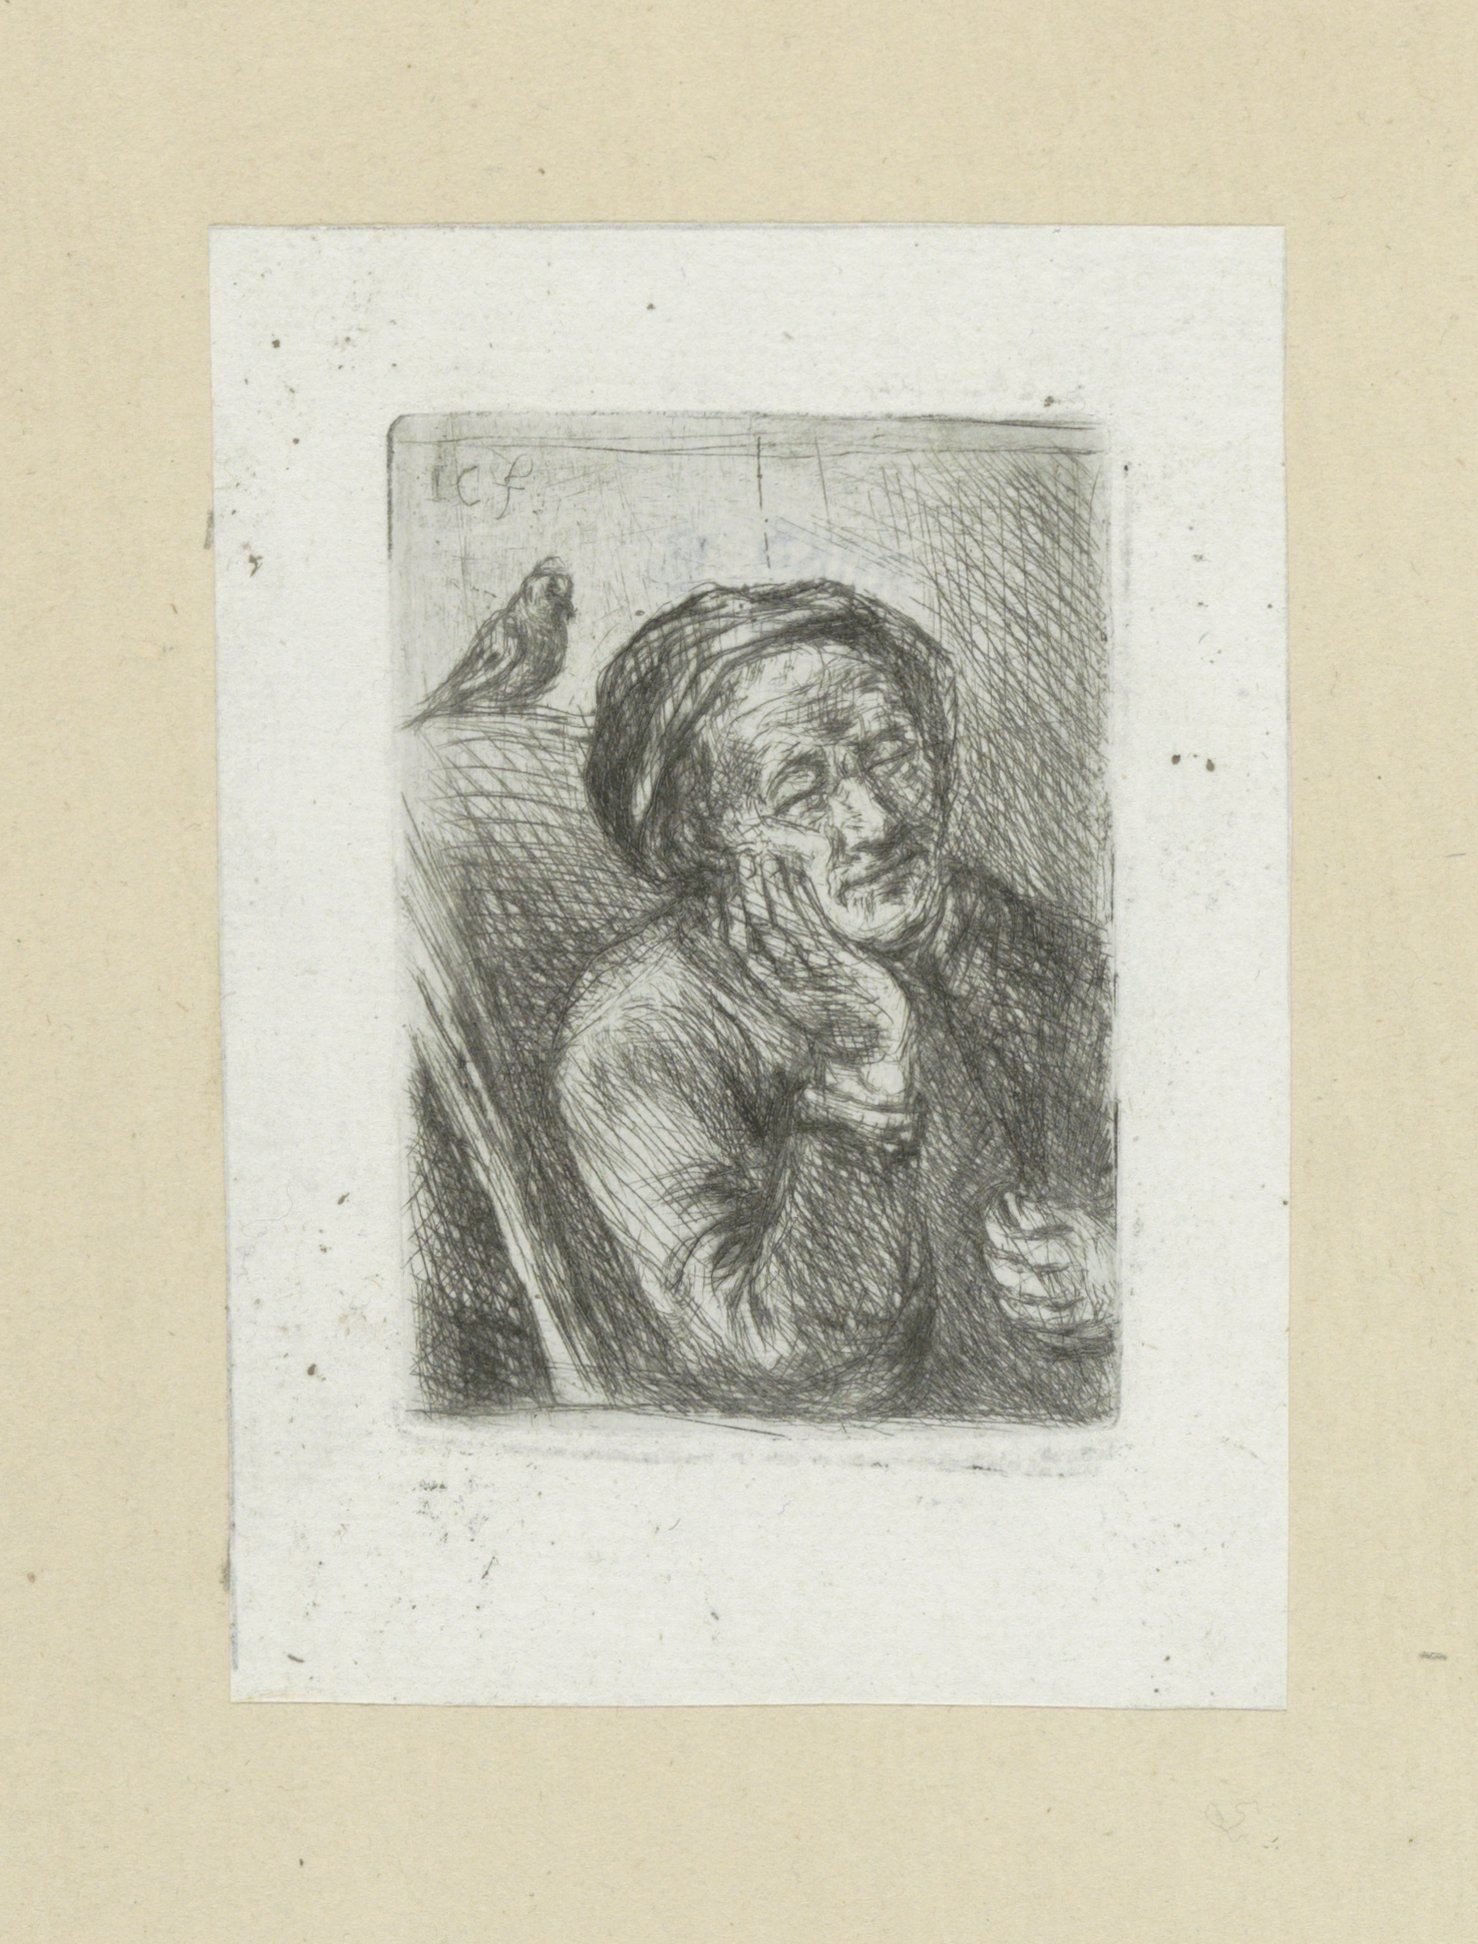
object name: print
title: Slapende oude man met vogel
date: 1802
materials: paper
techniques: drypoint, etching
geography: london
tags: birds, old man, sleeping; unconsciousness, morphology of human expression (+ old male (human being))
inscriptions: collector's mark: ‘B’, collector's mark: ‘RIJKS / MUSM’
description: Een slapende oude man in een stoel. Op de stoelleuning een vogel. De prent maakt deel uit van een album.